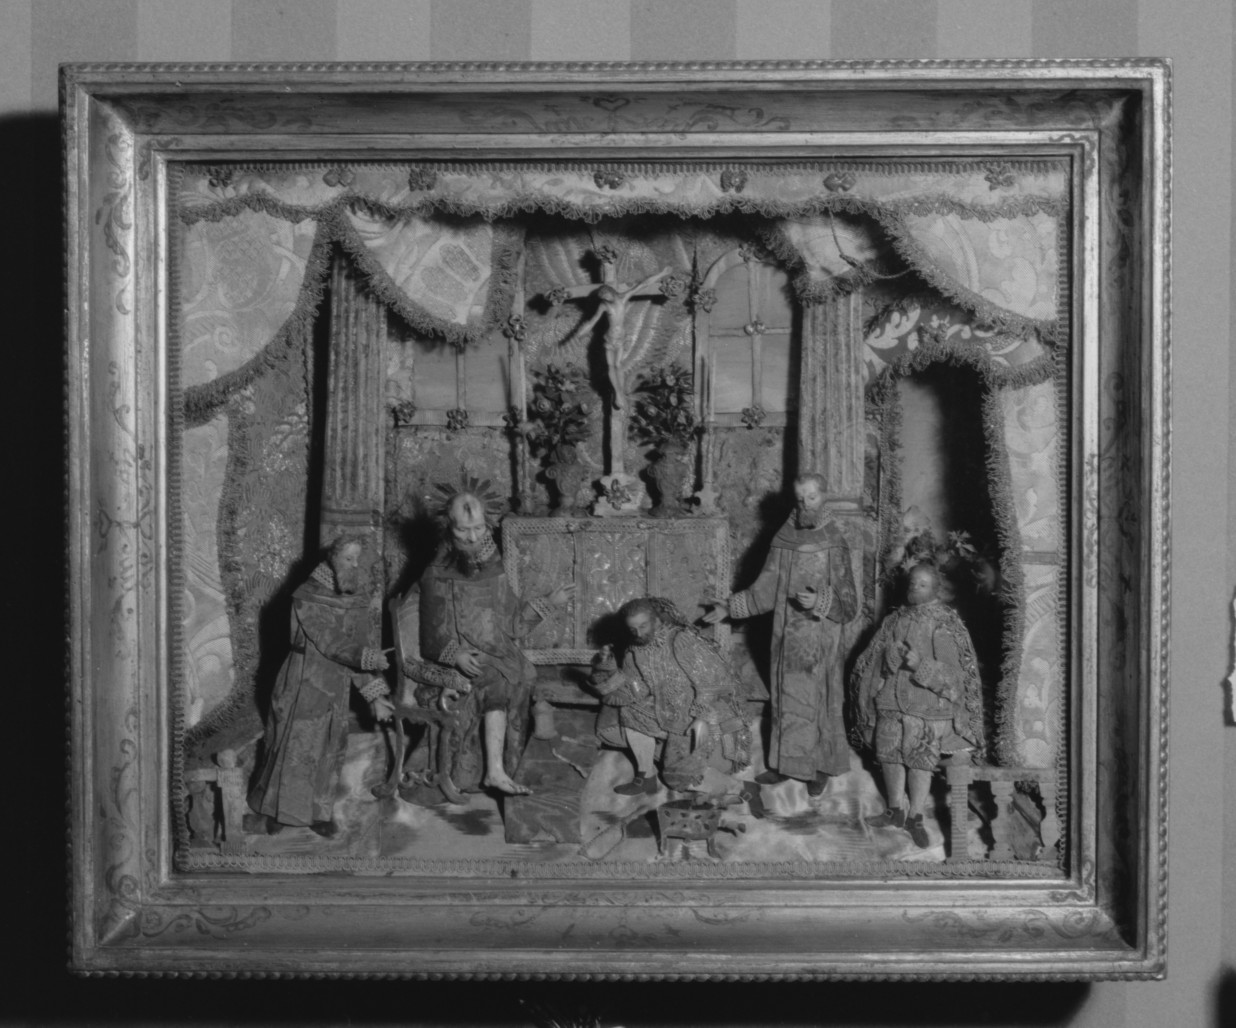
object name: sculpture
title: Miracle in the Life of St. Francis of Paola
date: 1701-1800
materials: foil, glass, paper, terracotta, wax, wood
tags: men,jesus